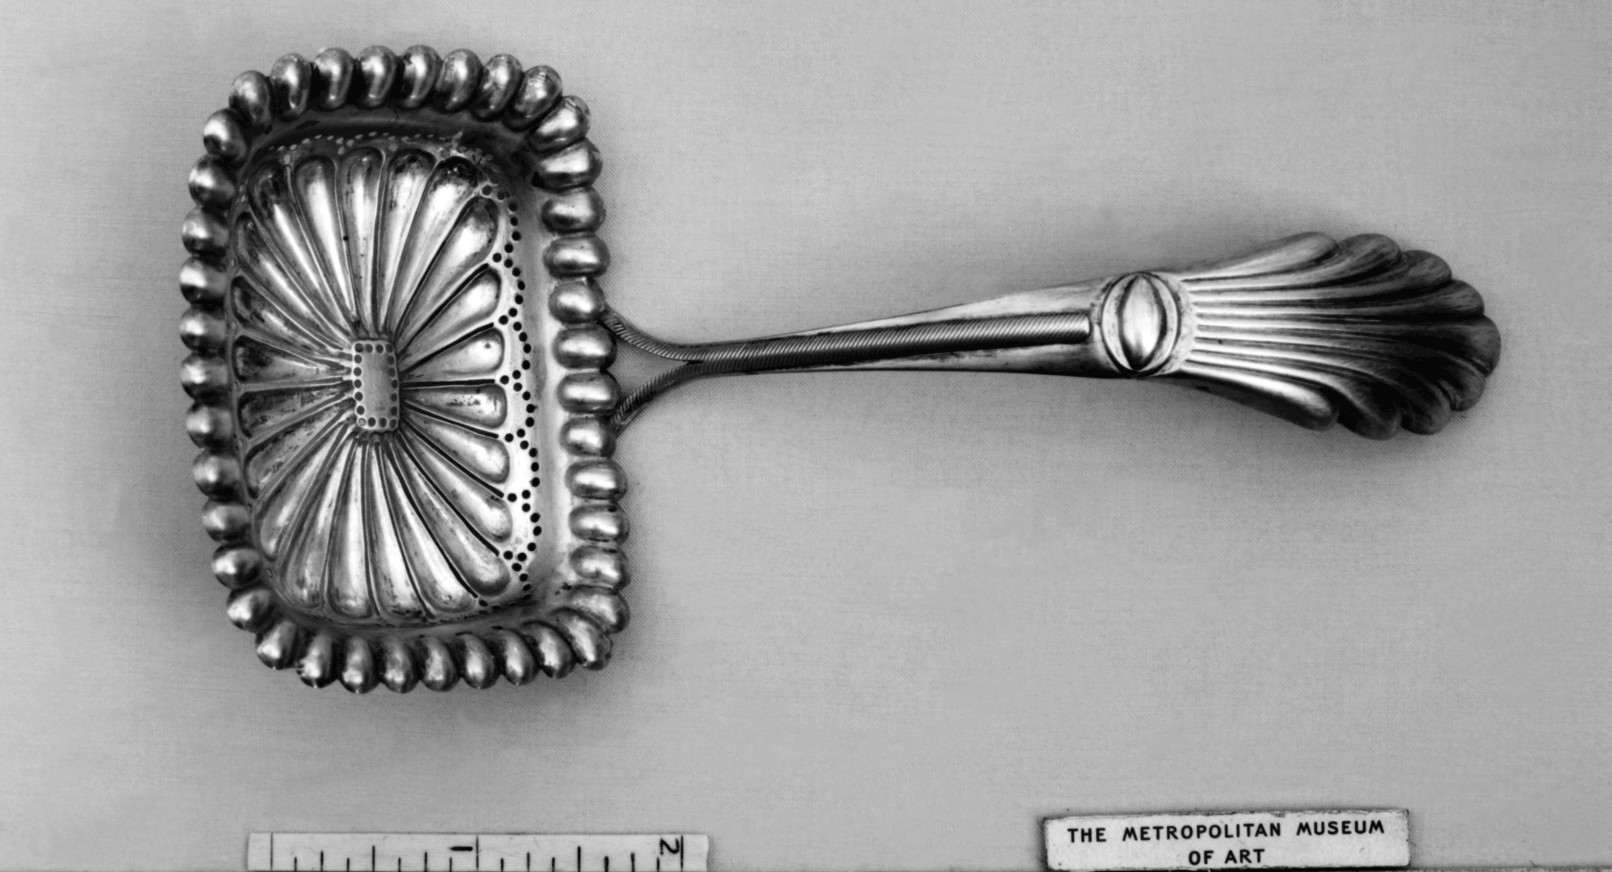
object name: sugar sifter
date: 1801-1900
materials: silver